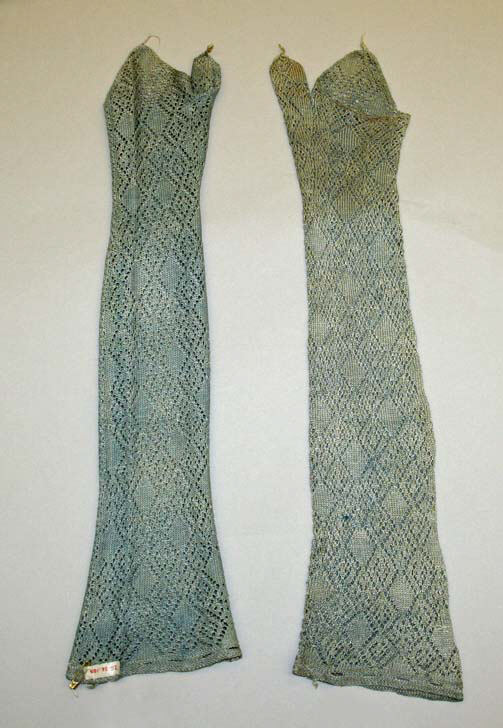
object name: mitt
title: Mitts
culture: italian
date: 1850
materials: silk